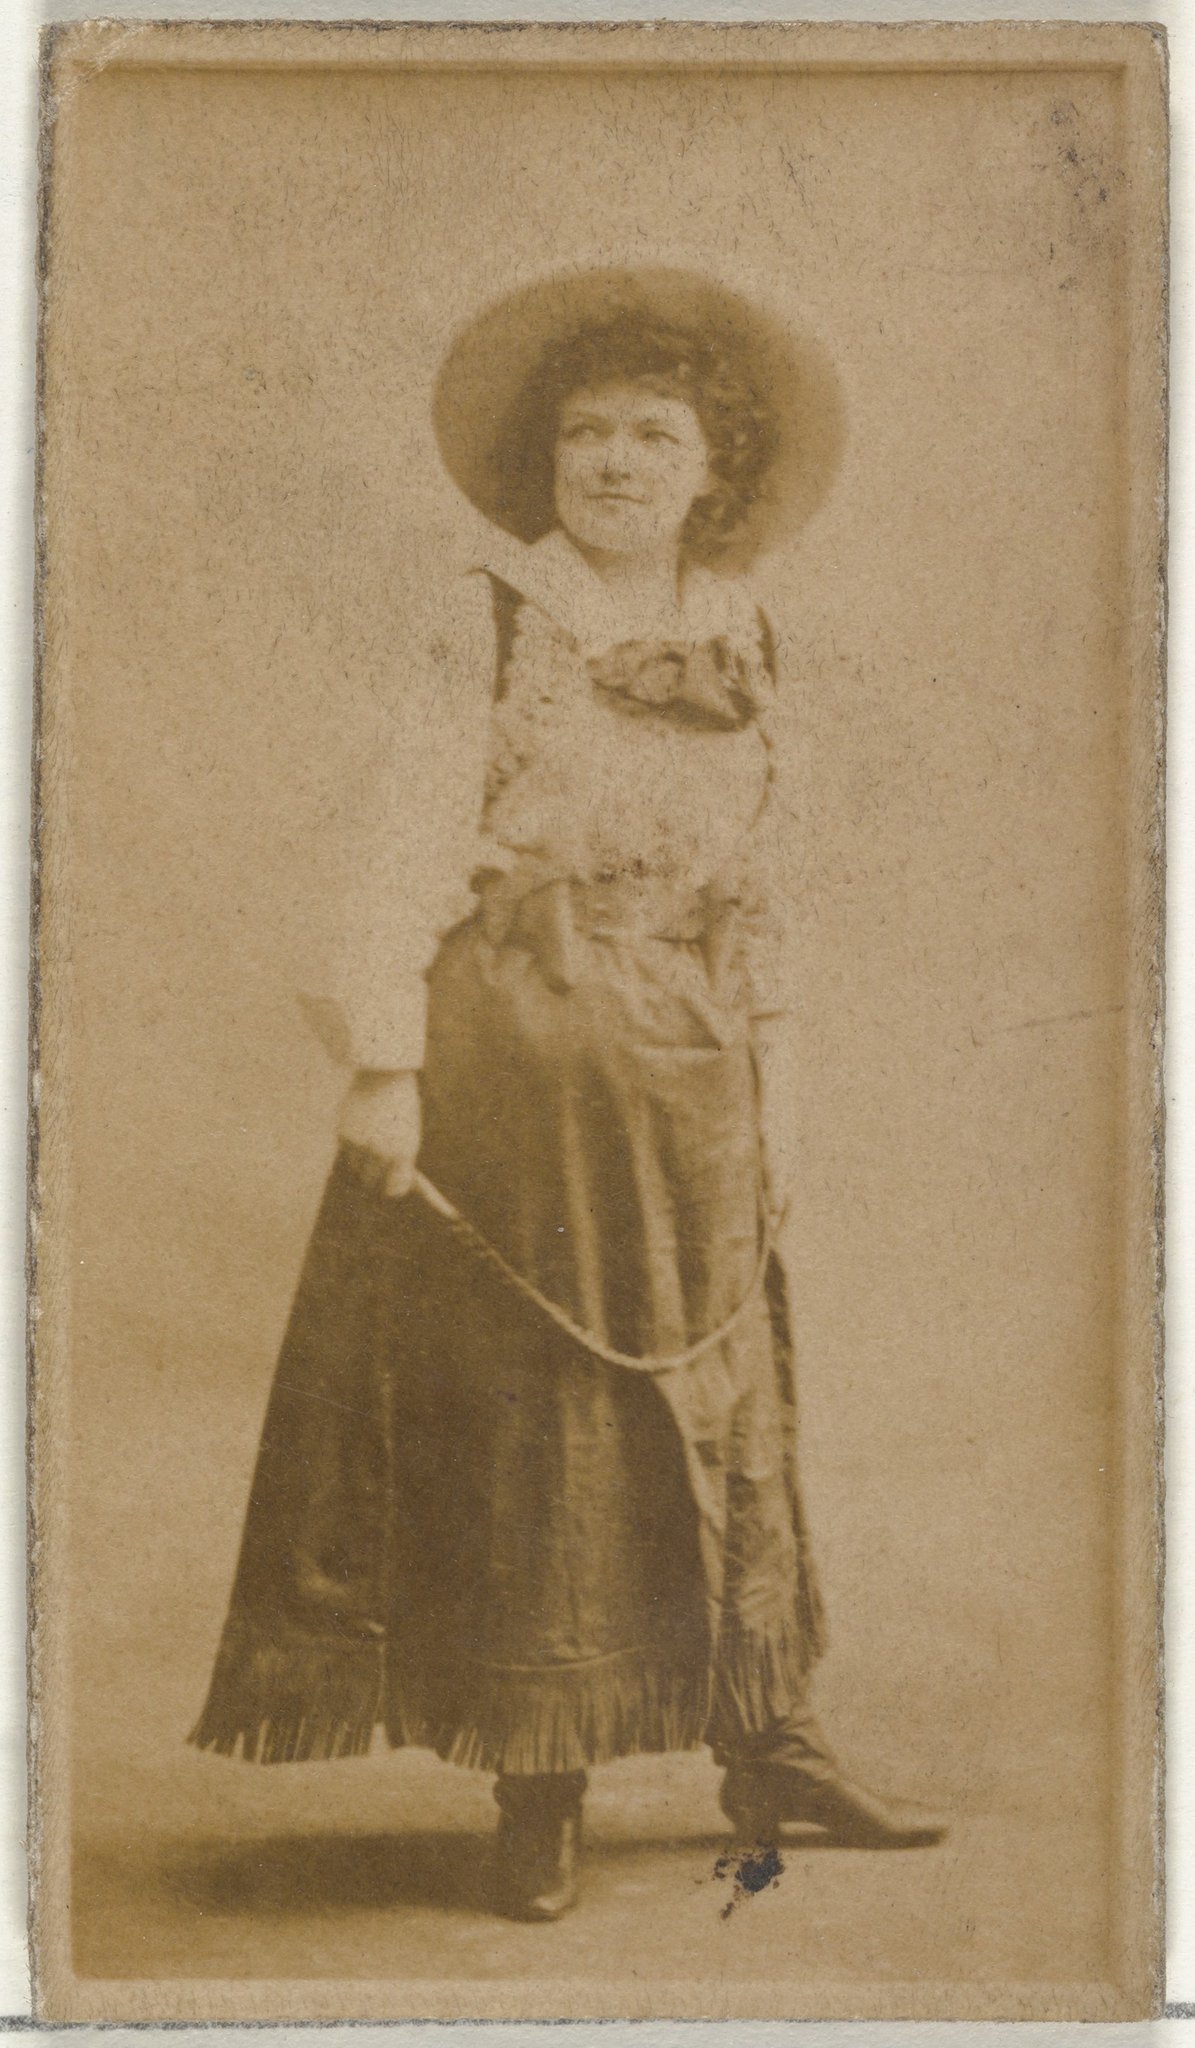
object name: photograph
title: [Actress wearing wide-brimmed hat], from the Actors and Actresses series (N145-8) issued by Duke Sons & Co. to promote Duke Cigarettes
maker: w. duke, sons & co.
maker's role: publisher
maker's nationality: american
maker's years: 1870-1920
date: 1891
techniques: albumen silver print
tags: portraits,women,actresses